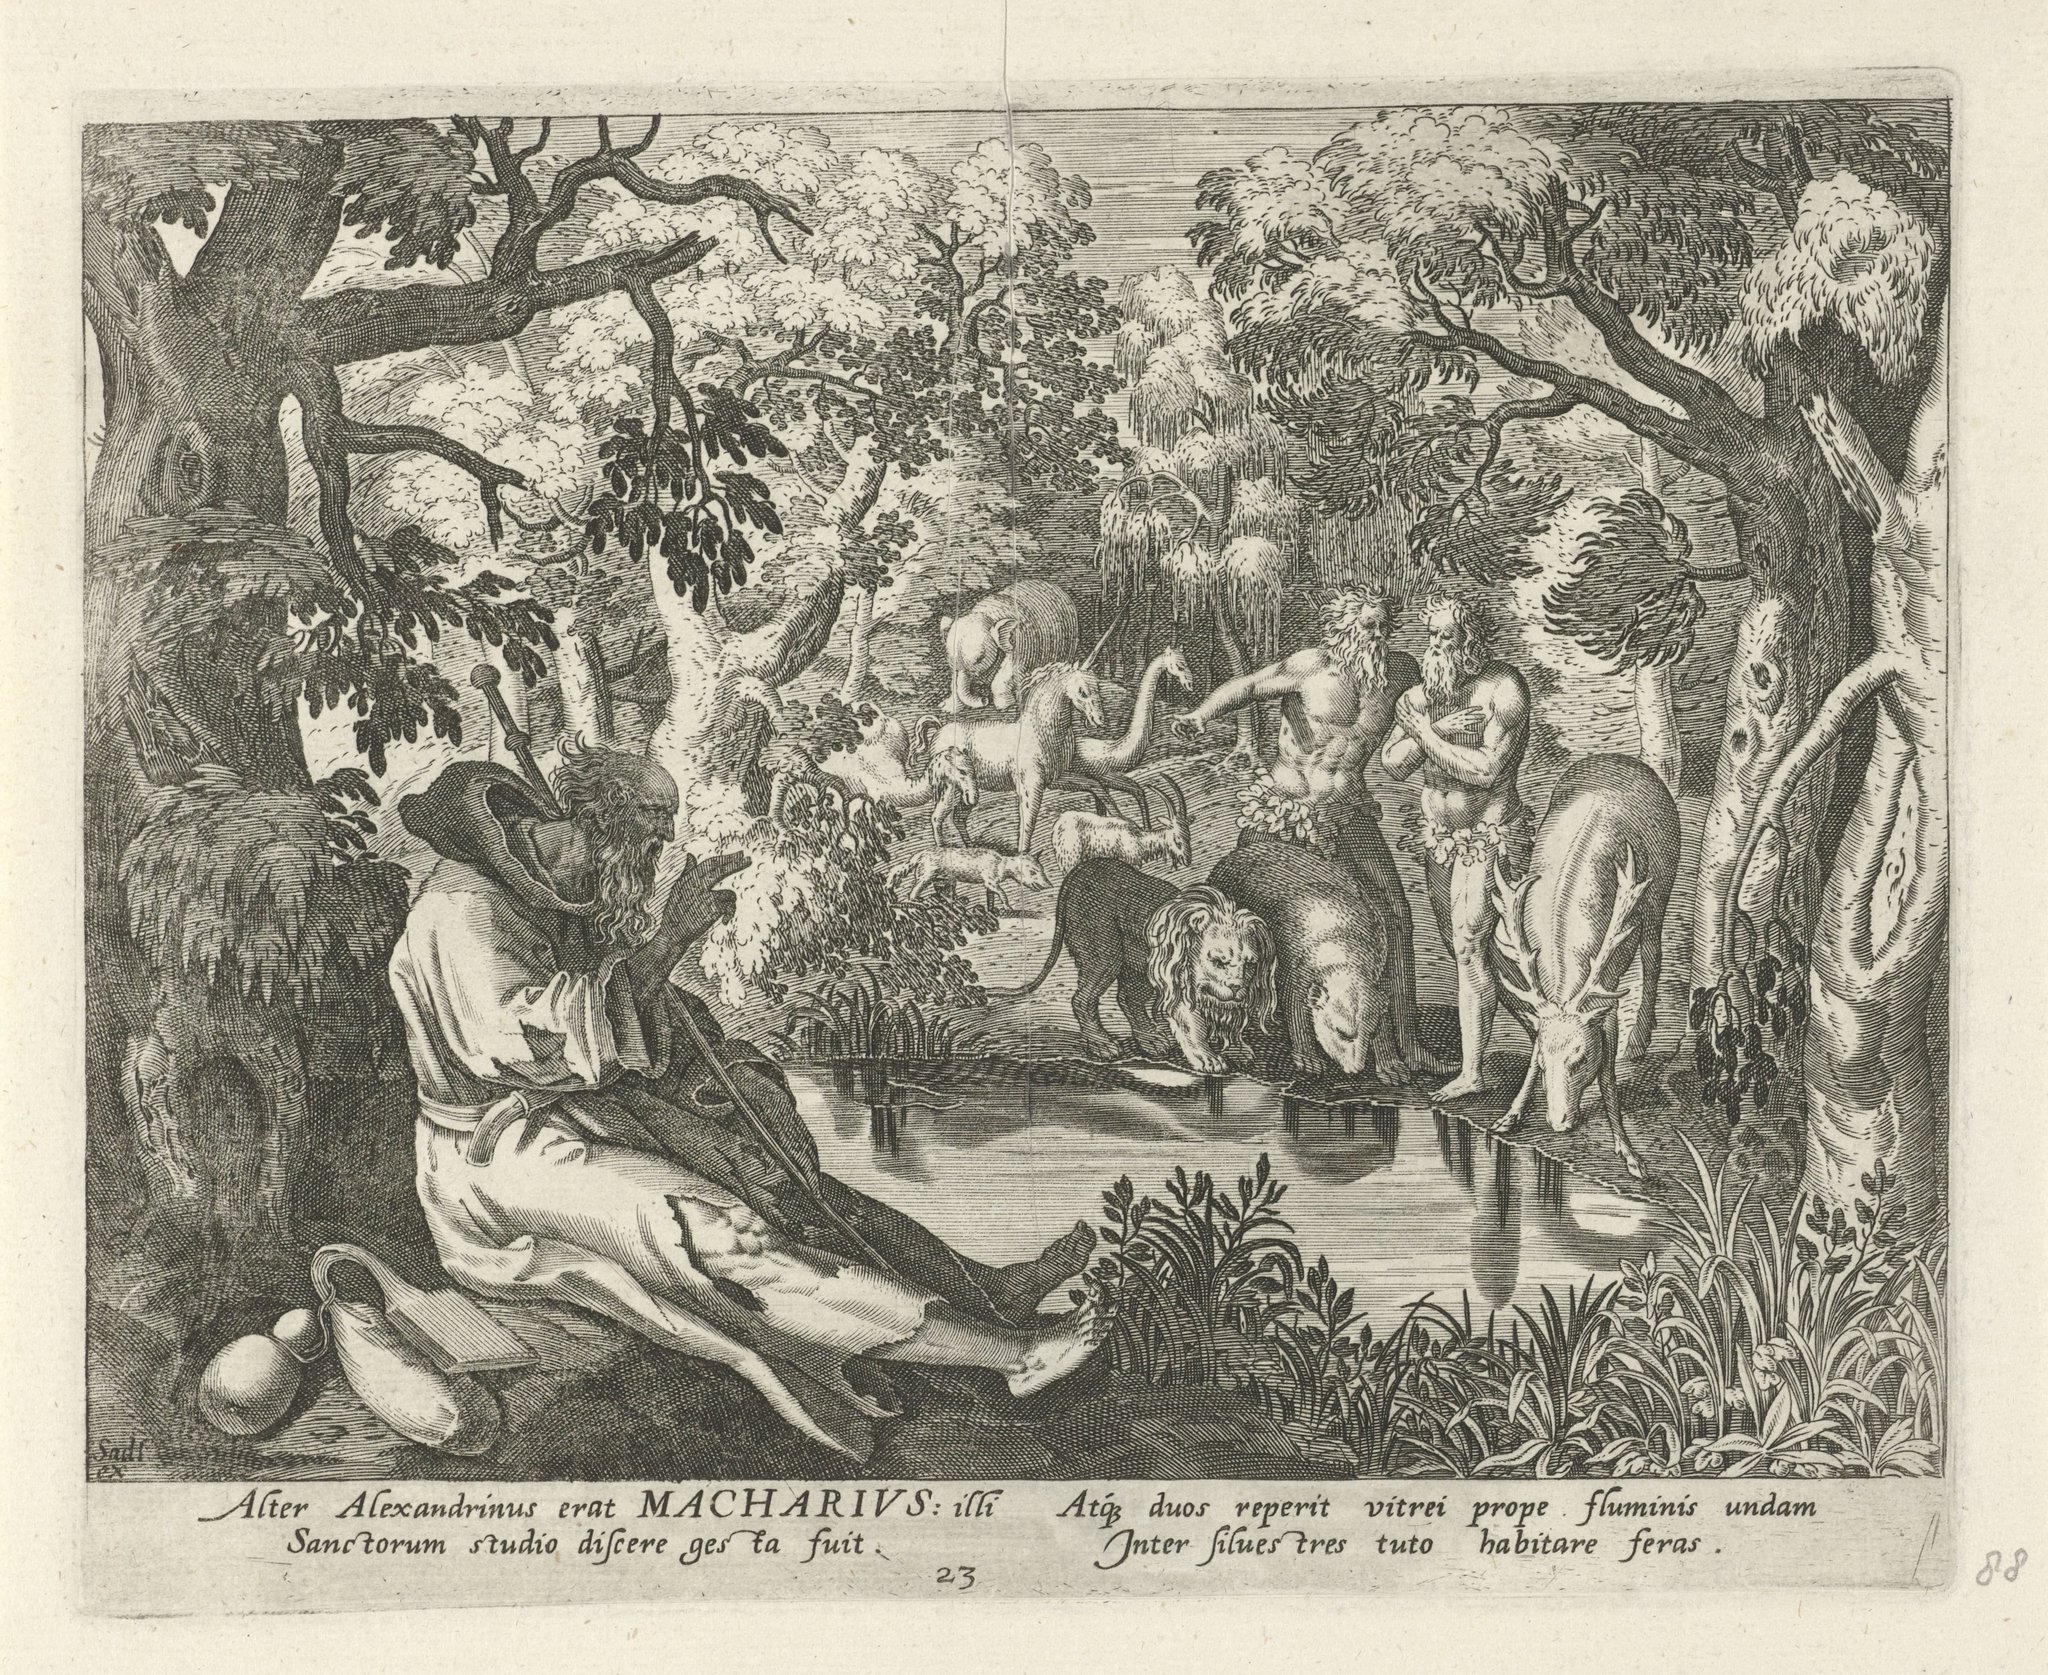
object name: print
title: Macarius van Alexandrië als kluizenaar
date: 1583-1588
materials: paper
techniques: engraving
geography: antwerp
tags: male saints (with name), unicorn, animals, wild man, wodewose, woodehouse, anchorite, hermit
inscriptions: collector's mark: Lugt 2228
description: De H. Macarius van Alexandrië als kluizenaar in de wildernis. Hij zit tegen een boom en maakt een zegenend gebaar. Op de achtergrond wilde dieren en twee wildemannen.